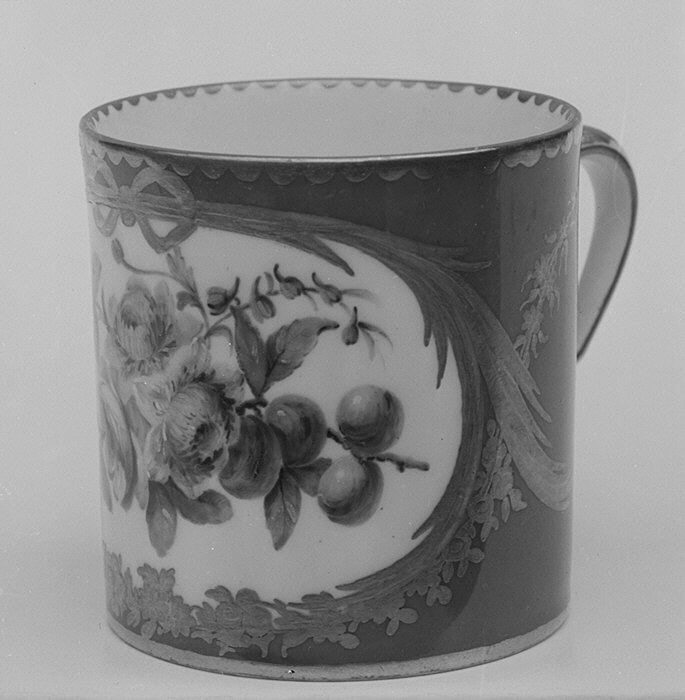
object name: cup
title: Cup (gobelet litron) (one of nine) (part of a a service)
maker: sèvres manufactory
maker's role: manufactory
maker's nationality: french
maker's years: 1740-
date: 1787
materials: soft paste porcelain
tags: fruit,flowers